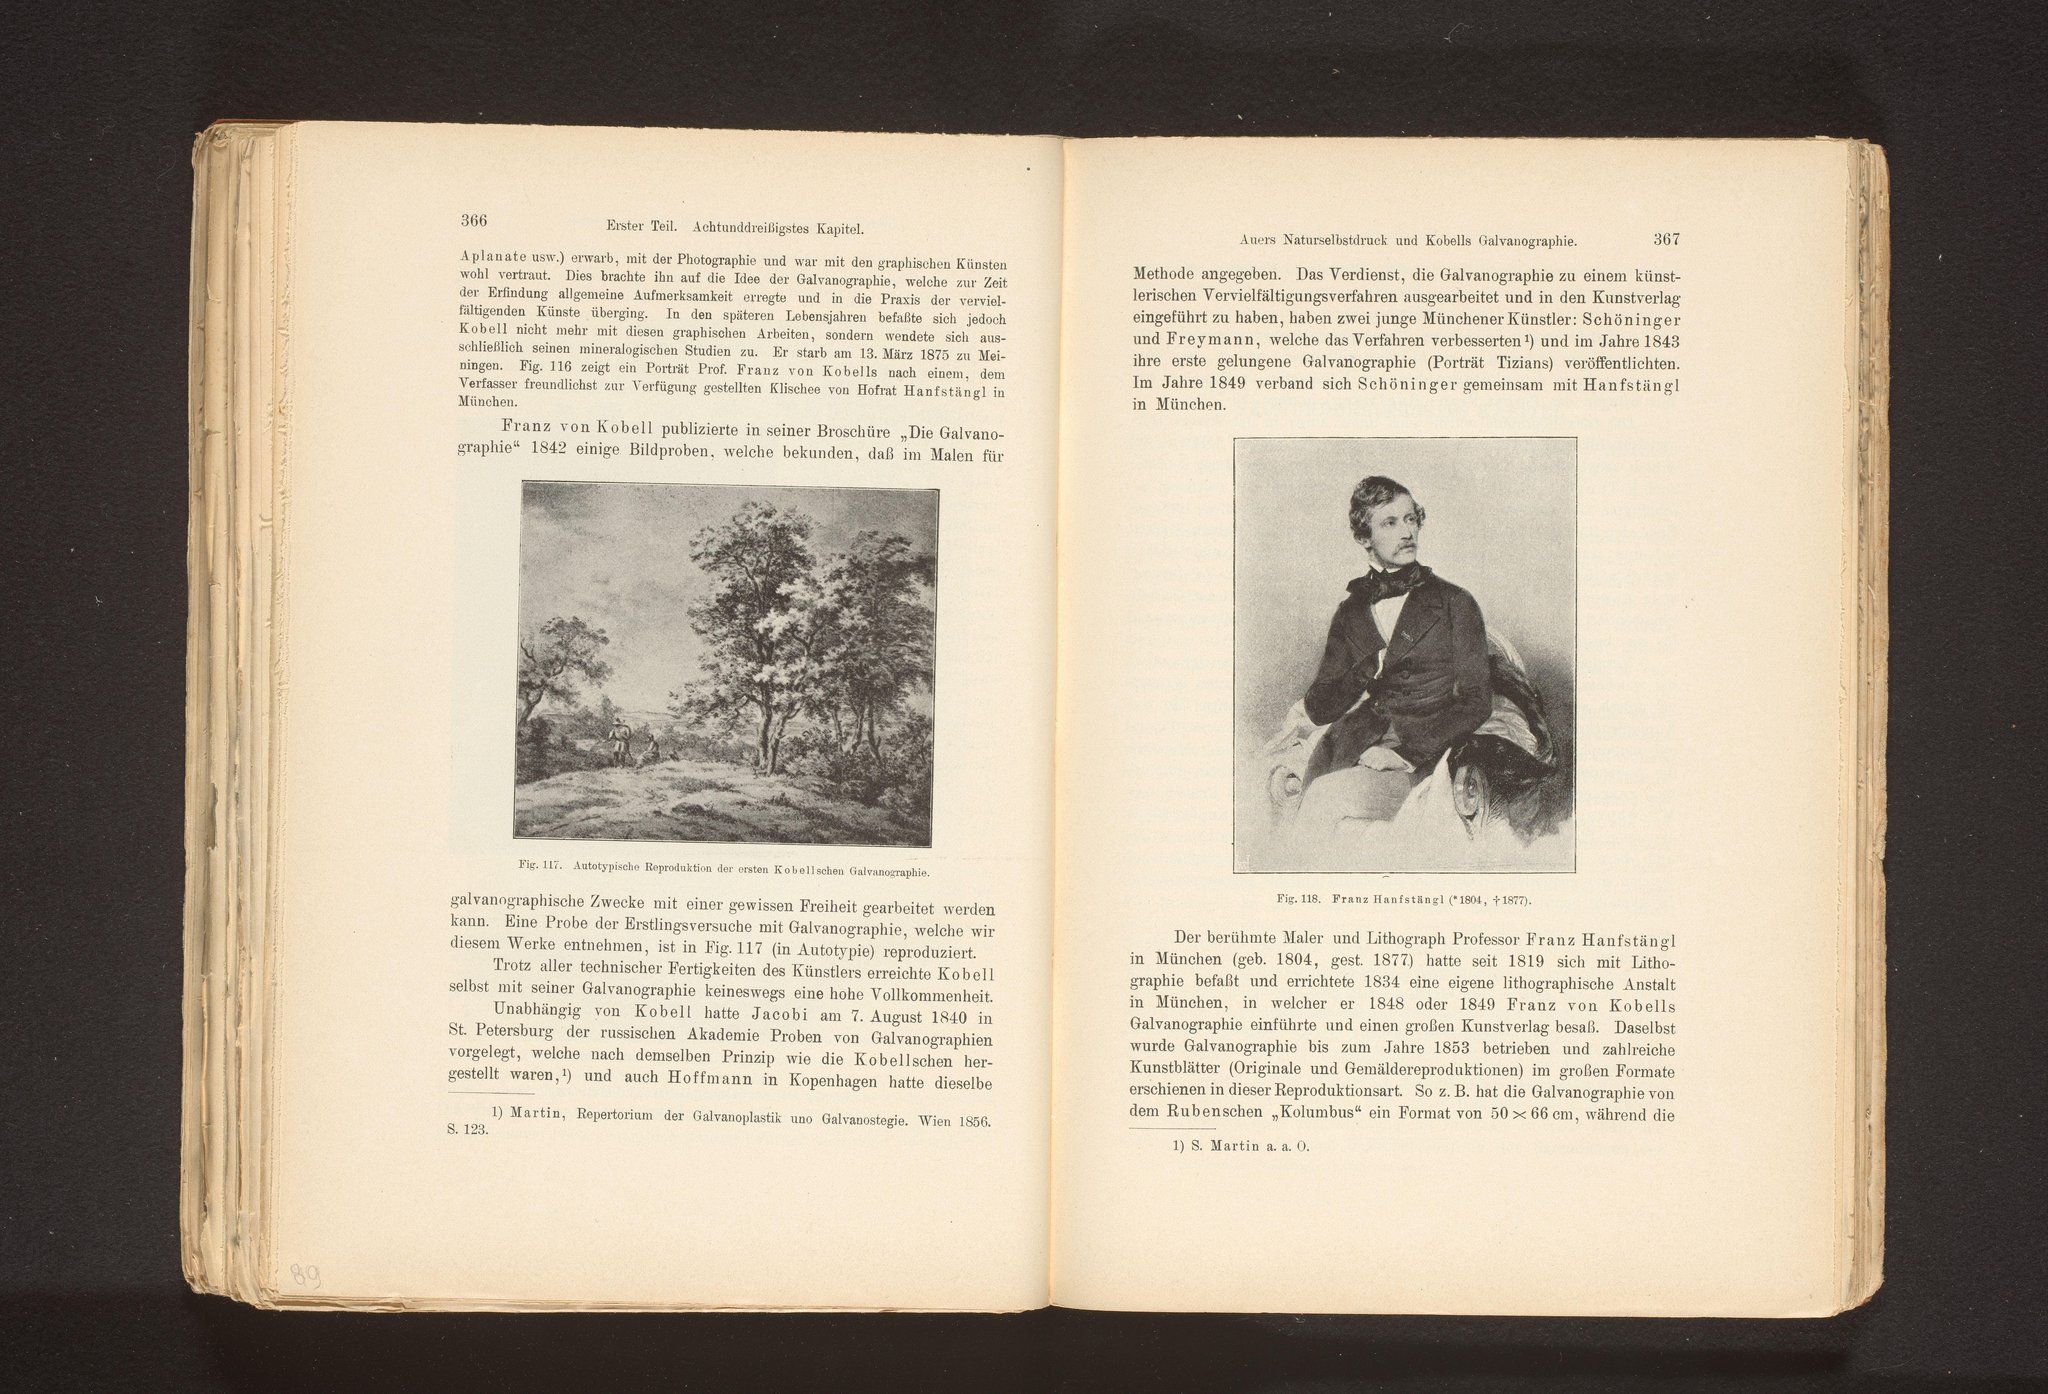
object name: photomechanical print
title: Fotoreproductie van een schilderij, voorstellende een weidelandschap met twee figuren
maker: Anonymous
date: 1900-1905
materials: paper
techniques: autotype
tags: meadow, pasture (+ landscape with figures, staffage)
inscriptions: inscription: ‘Autotypische (...) Galvanographie.’, number: ‘Fig. 117.’